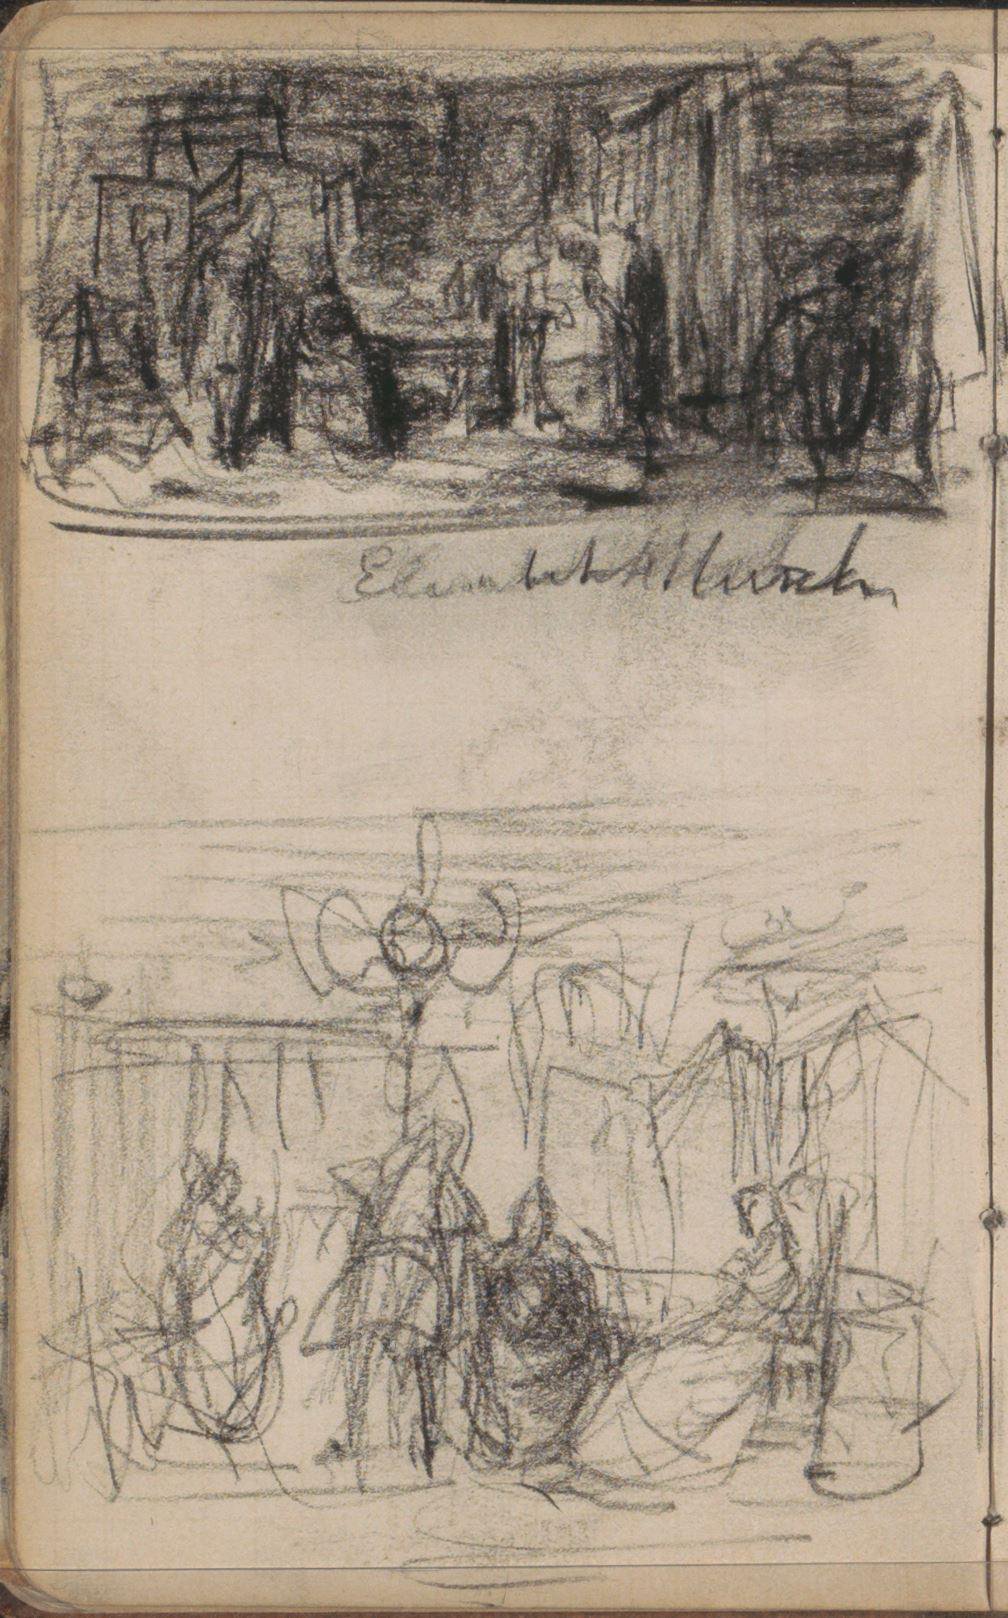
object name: sketchbook leaf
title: Figuren in een interieur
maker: marius bauer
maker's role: draughtsman, print maker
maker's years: 1867-1932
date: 1879-1885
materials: chalk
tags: anatomy (non-medical), interior of the house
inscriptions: annotation: ‘Ela[...] het AHusch[...]’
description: Pagina 39 uit een schetsboek met 58 bladen.